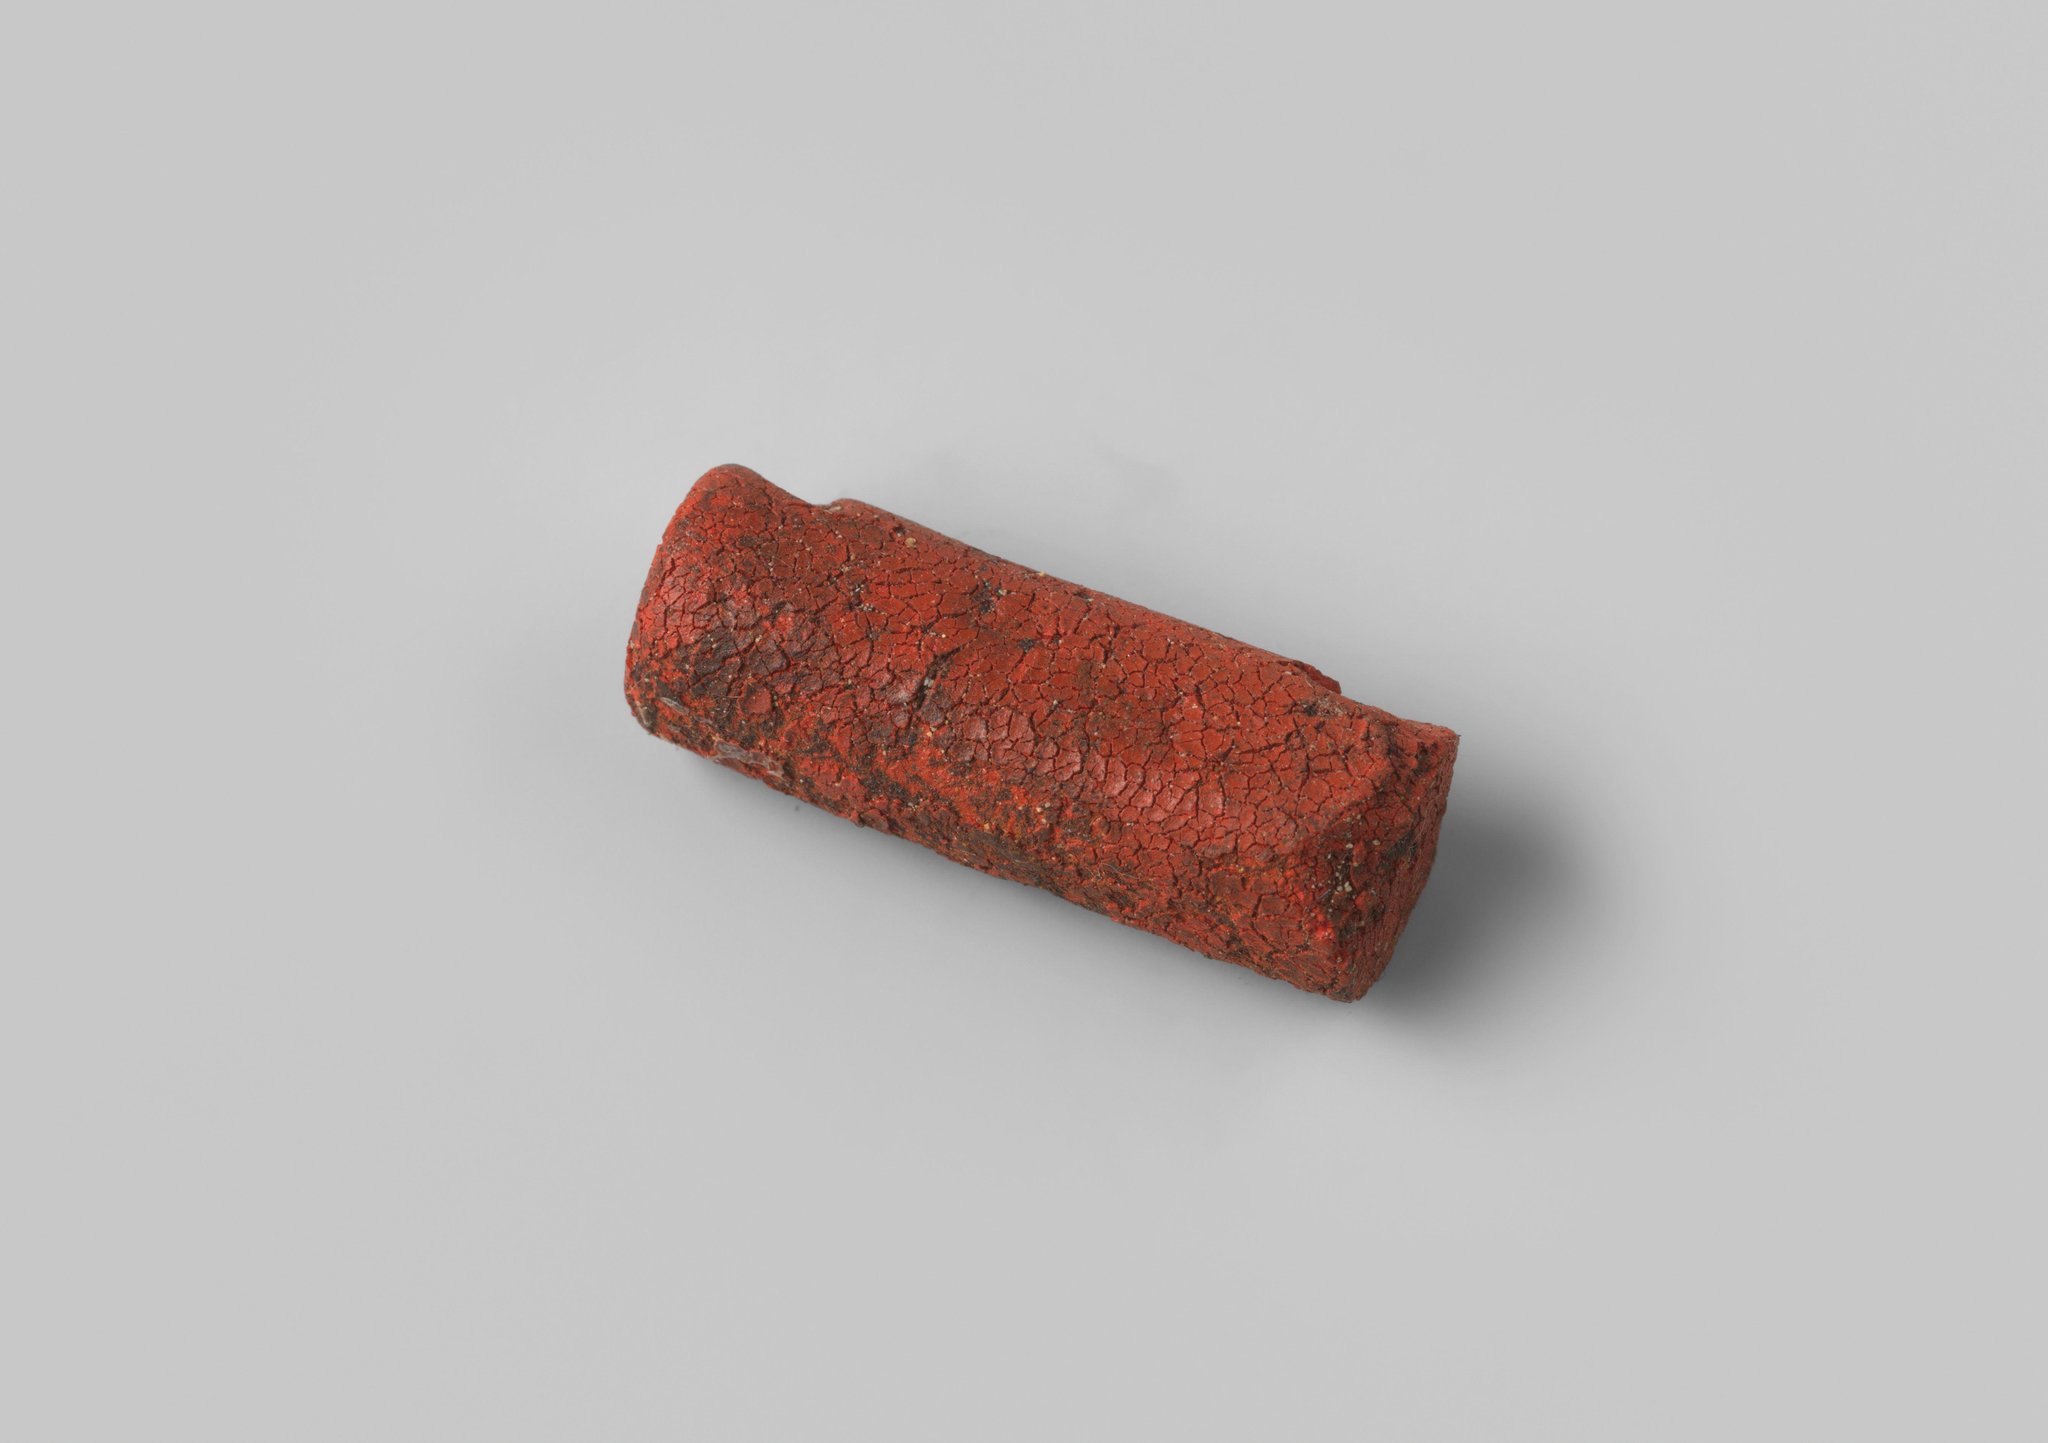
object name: sealing wax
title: Zegellak uit het wrak van de Oost-Indiëvaarder Hollandia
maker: Anonymous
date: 1700-1743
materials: wax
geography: netherlands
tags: verenigde oostindische compagnie, hollandia (schip), annet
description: Marking and proving, sealing wax, red; fragm, id NG 1980-27H2020, one end broken.